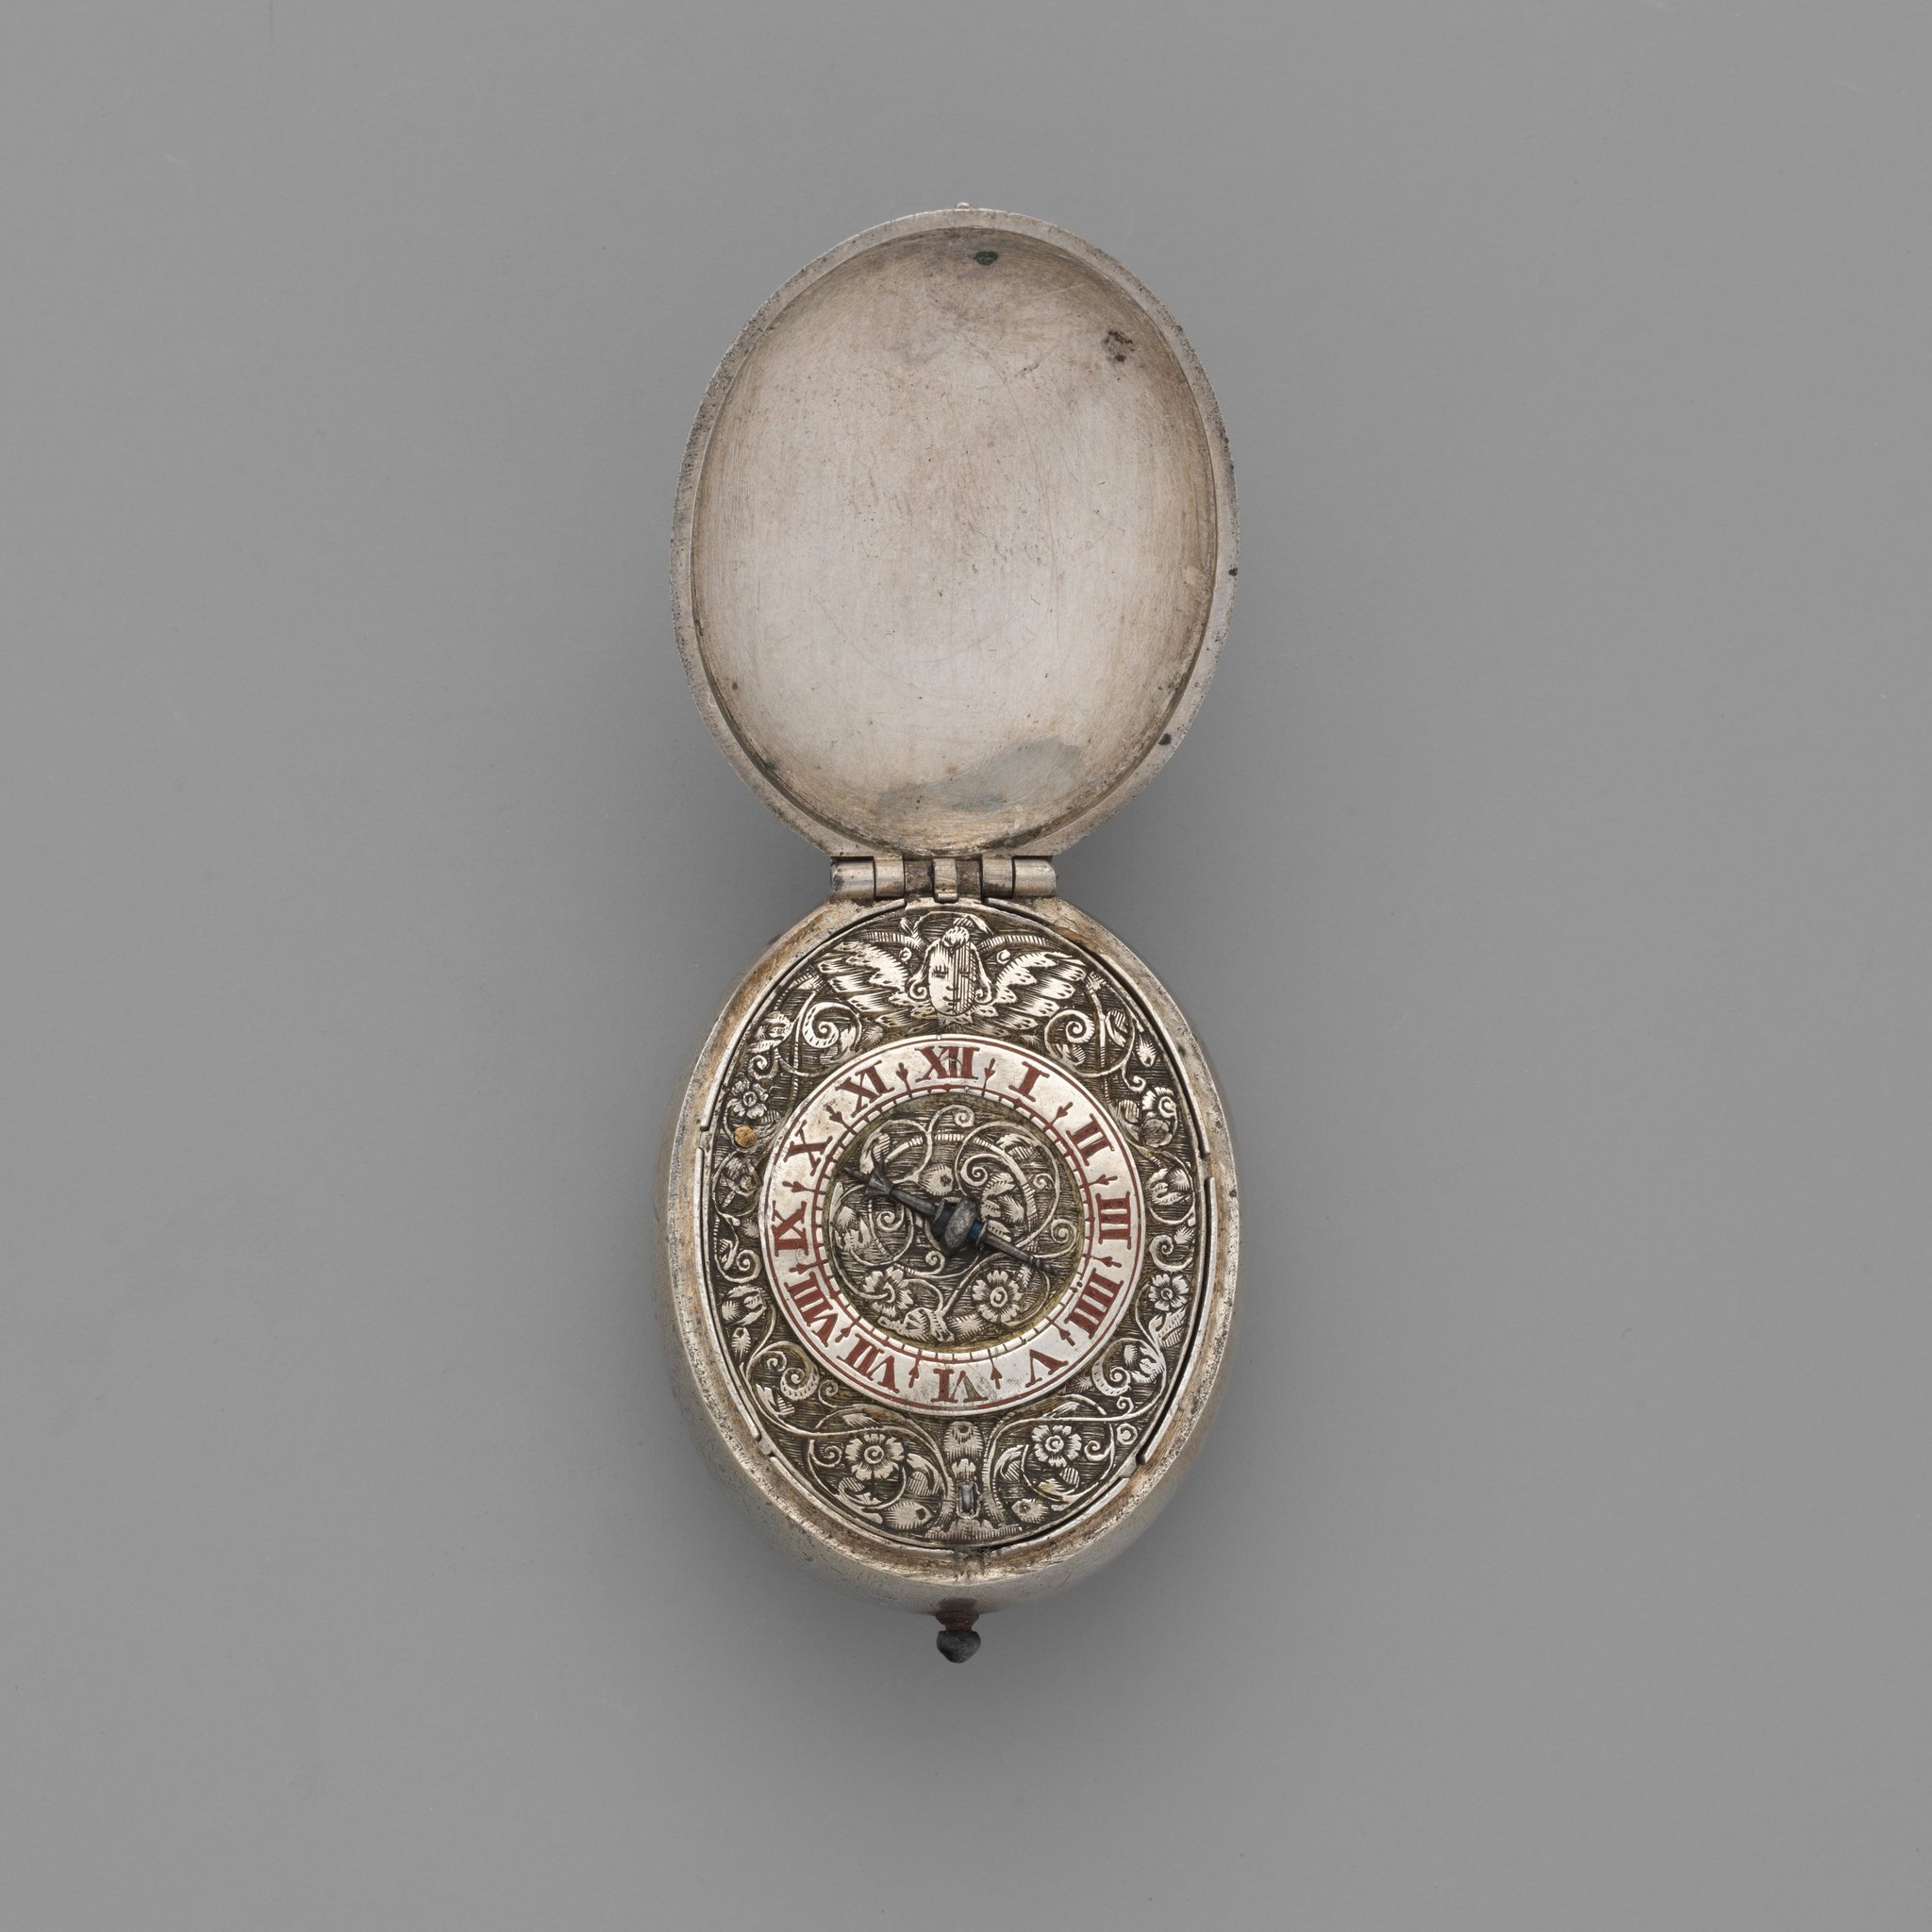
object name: watch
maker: richard masterson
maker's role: maker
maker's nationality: british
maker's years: 1553-1653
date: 1630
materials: gilt brass, silver, steel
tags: faces,flowers